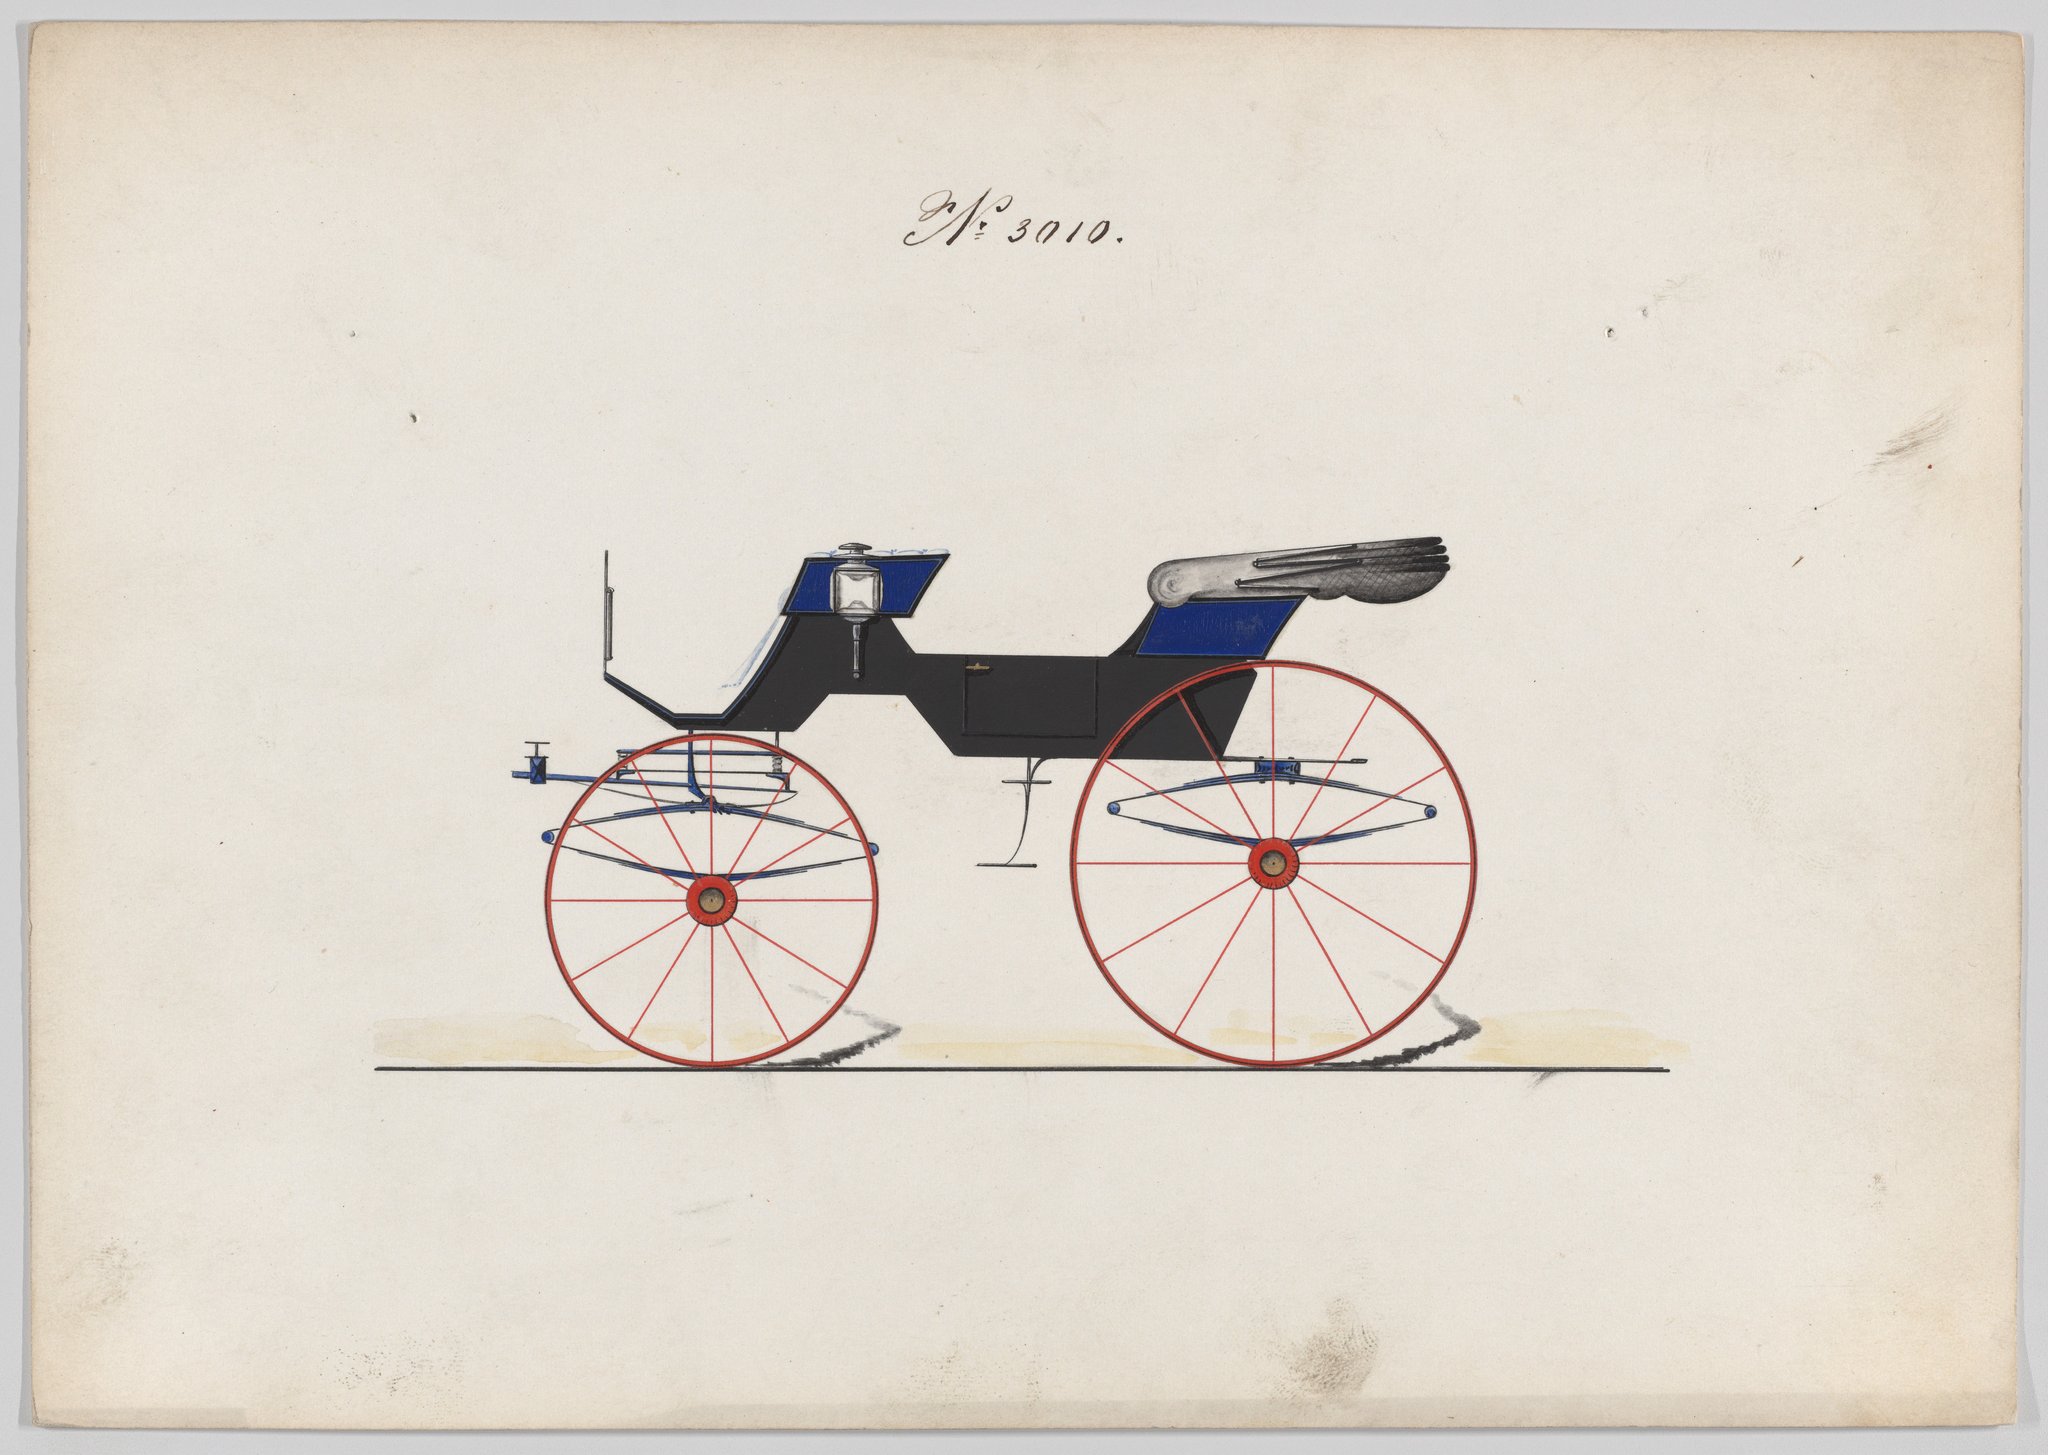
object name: drawing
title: Design for 2 seat Phaeton, no. 3010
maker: brewster & co.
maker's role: manufacturer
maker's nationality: american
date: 1874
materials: gouache, gum arabic, ink, watercolor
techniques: pen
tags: carriages